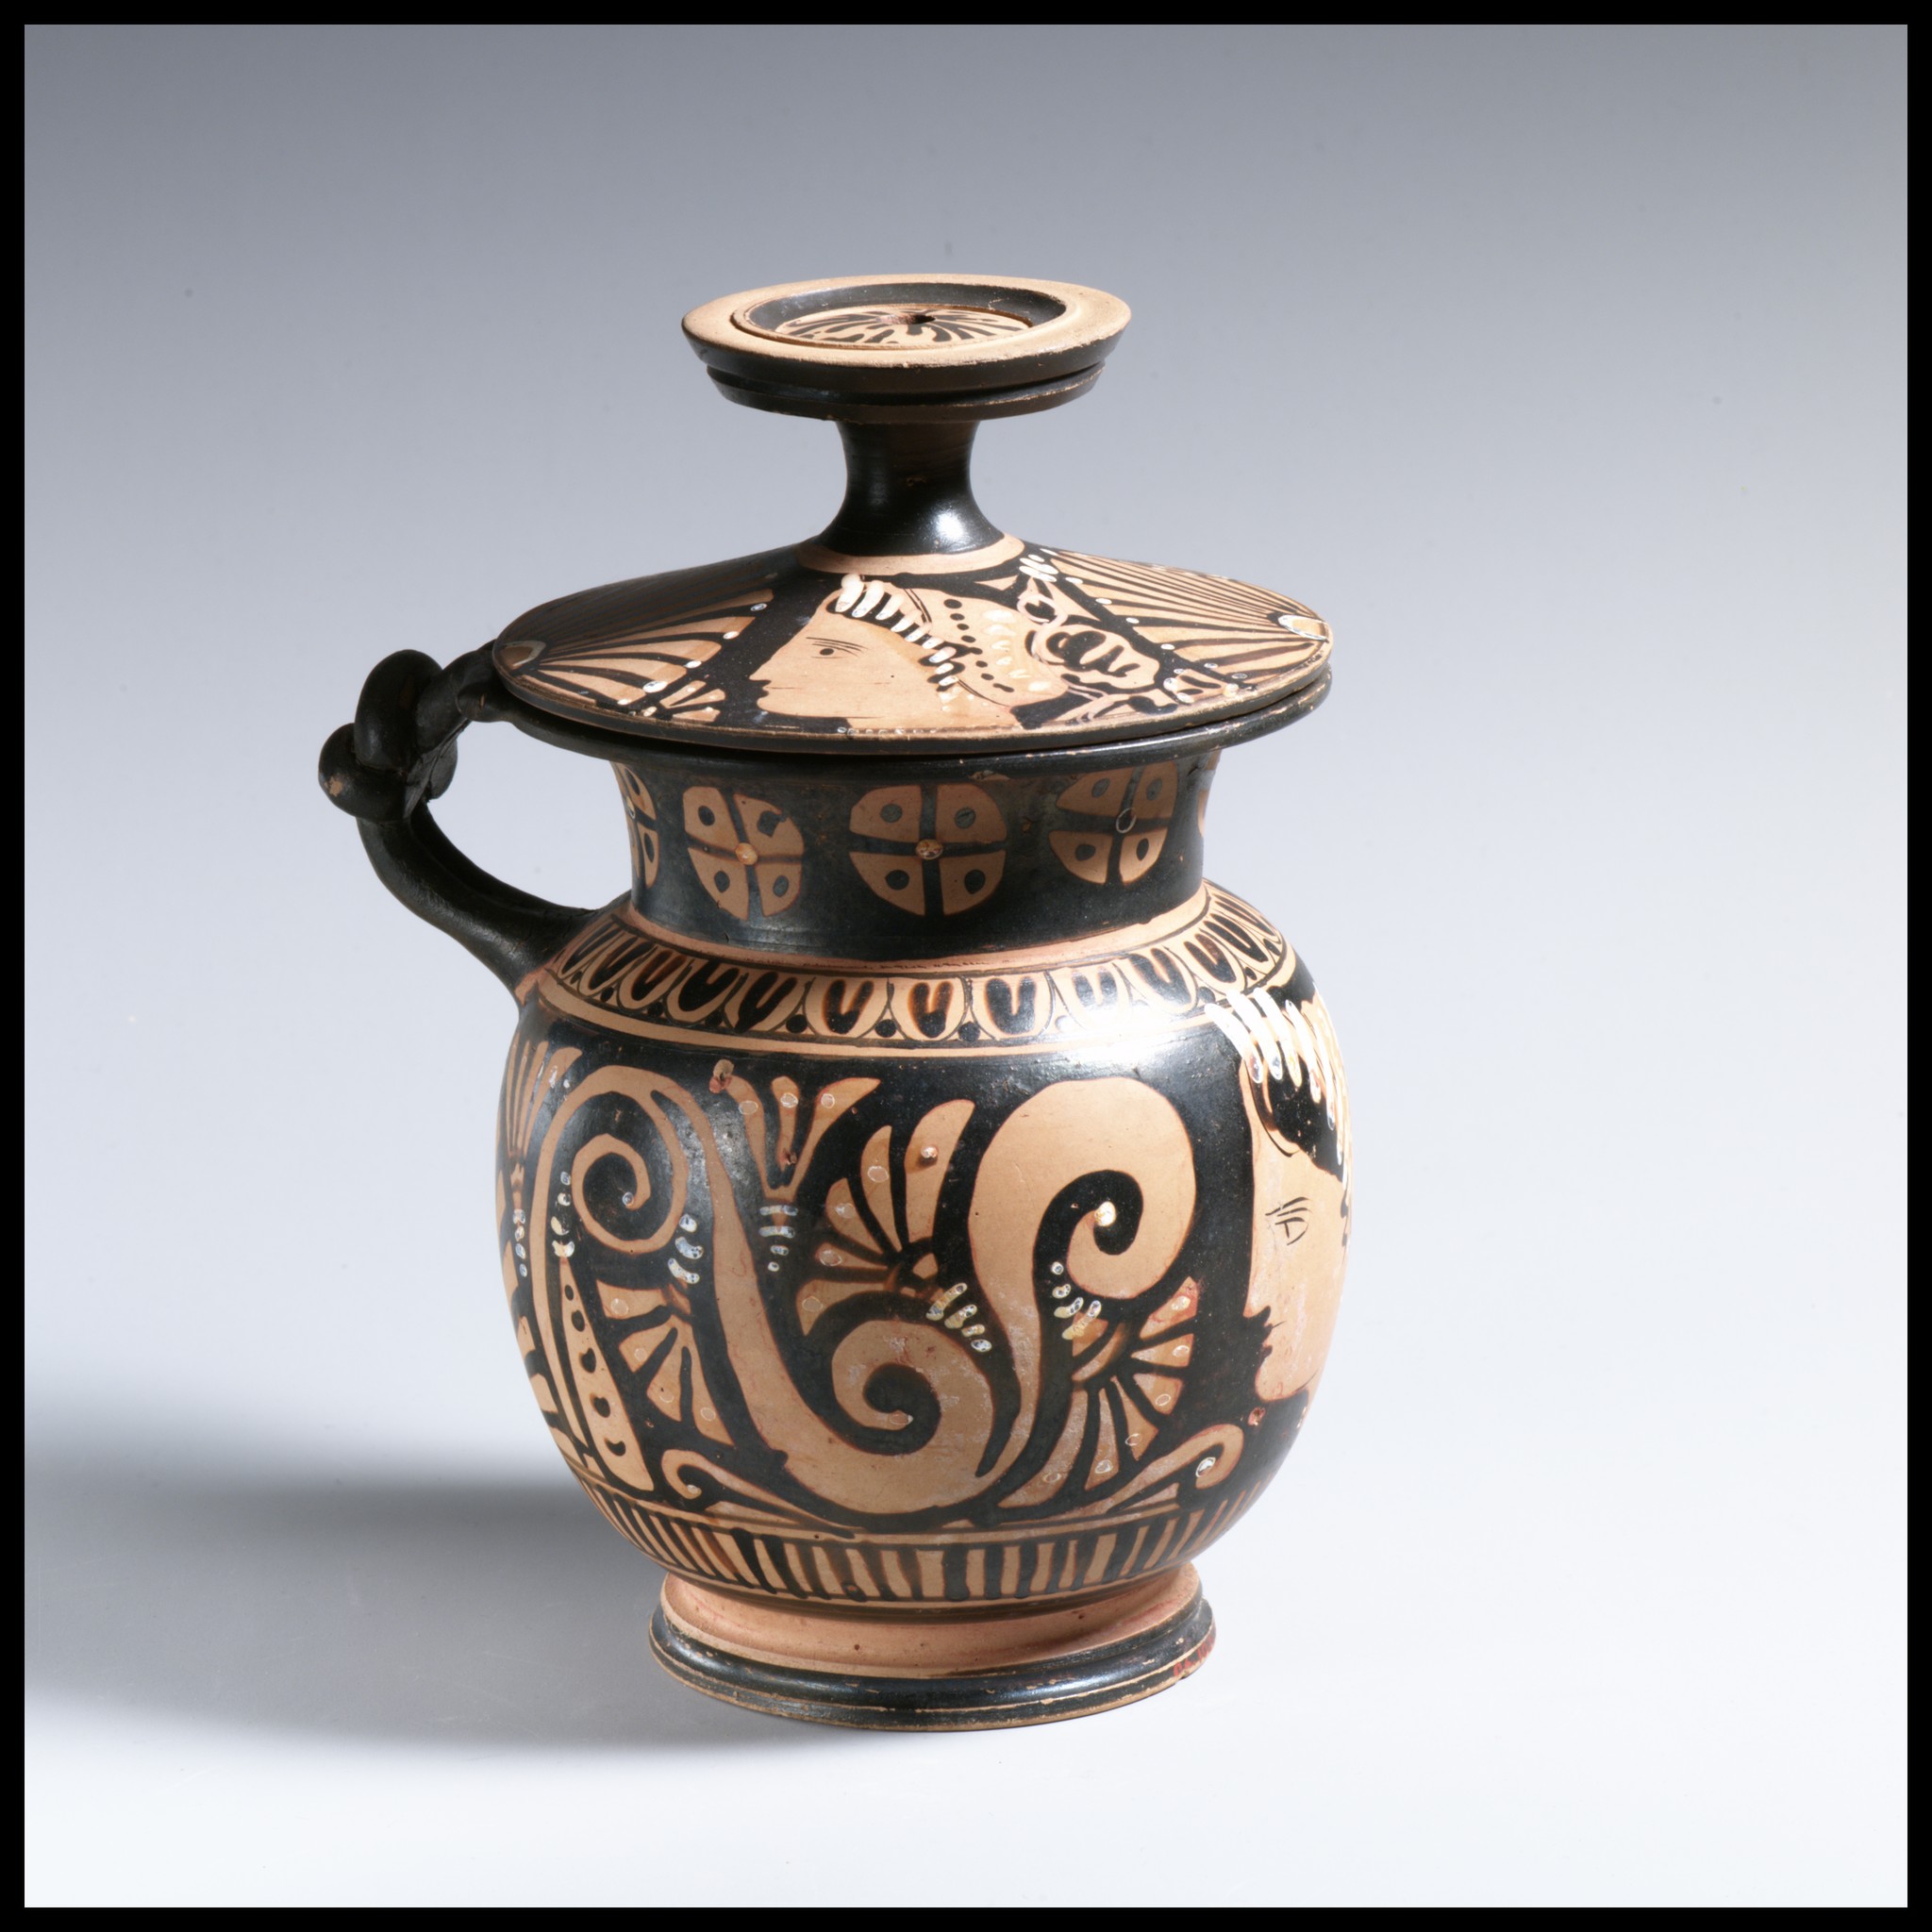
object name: mug with lid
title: Terracotta mug with lid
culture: greek, south italian, apulian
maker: painter of vienna 113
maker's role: artist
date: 340-320 BCE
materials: terracotta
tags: heads,women